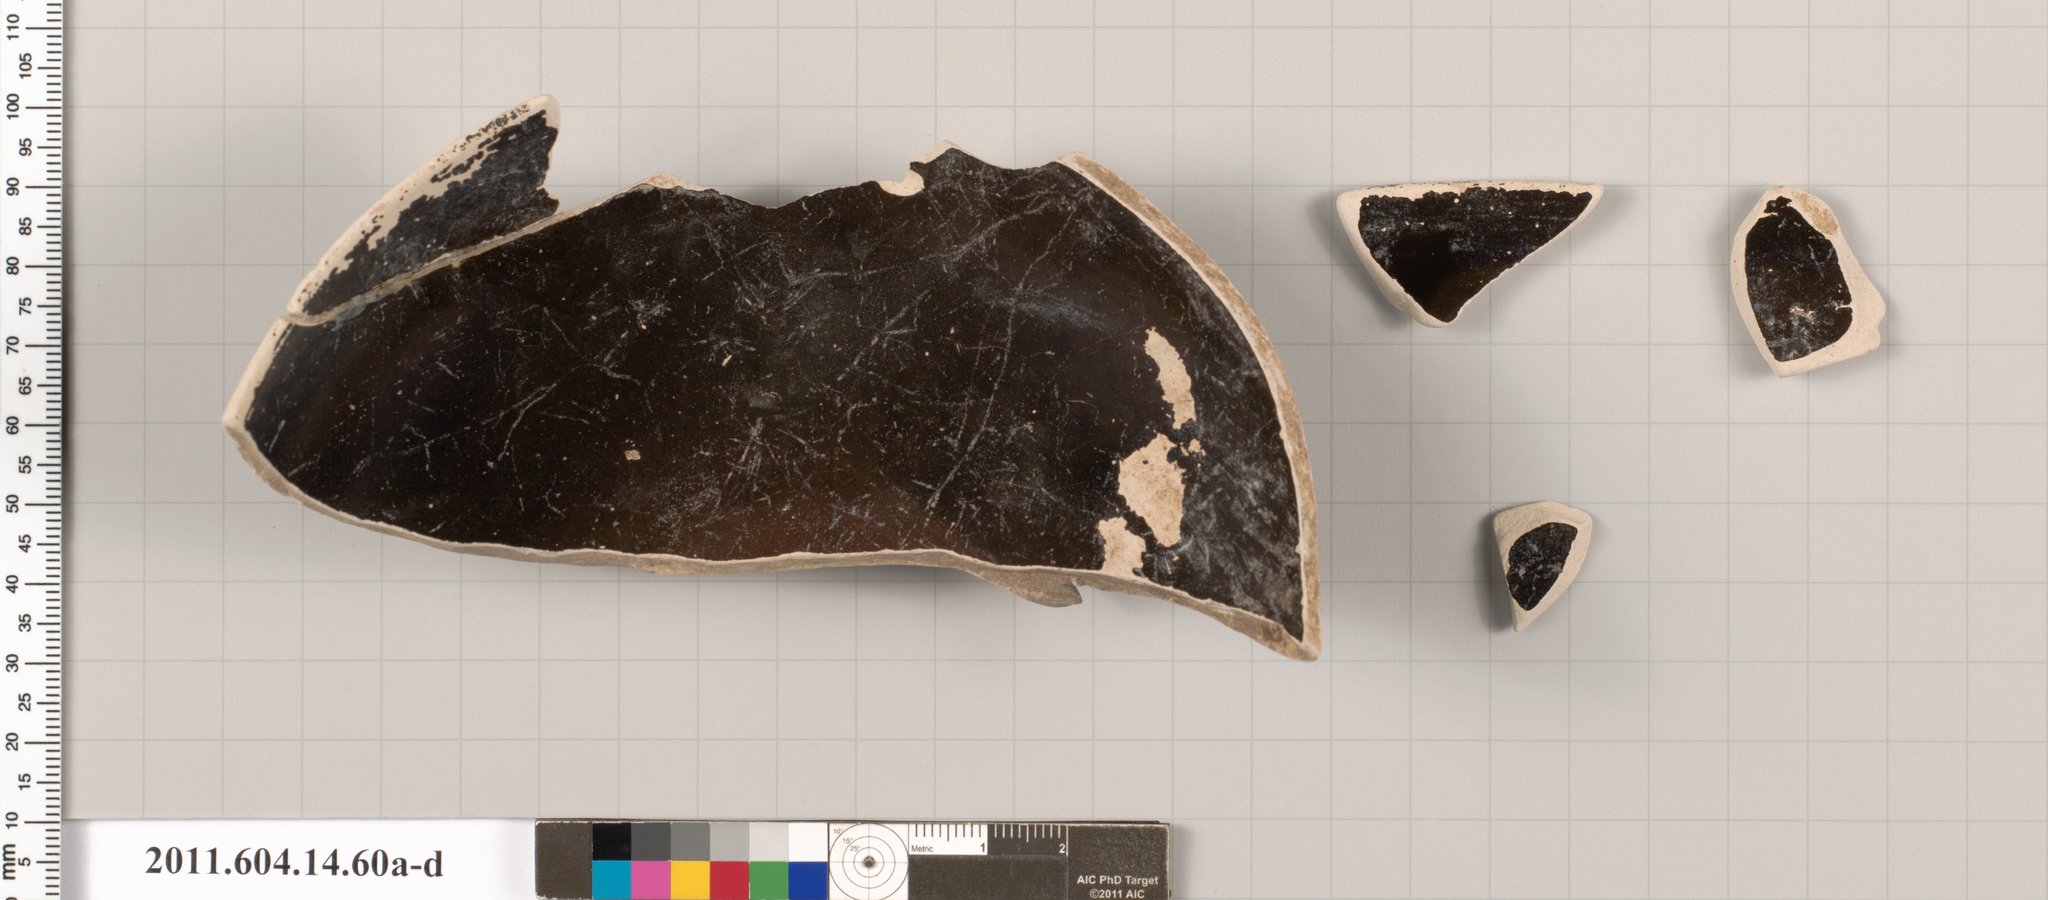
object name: fragment of a bowl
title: Terracotta fragments of a bowl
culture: unknown fabric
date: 600-301 BCE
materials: terracotta